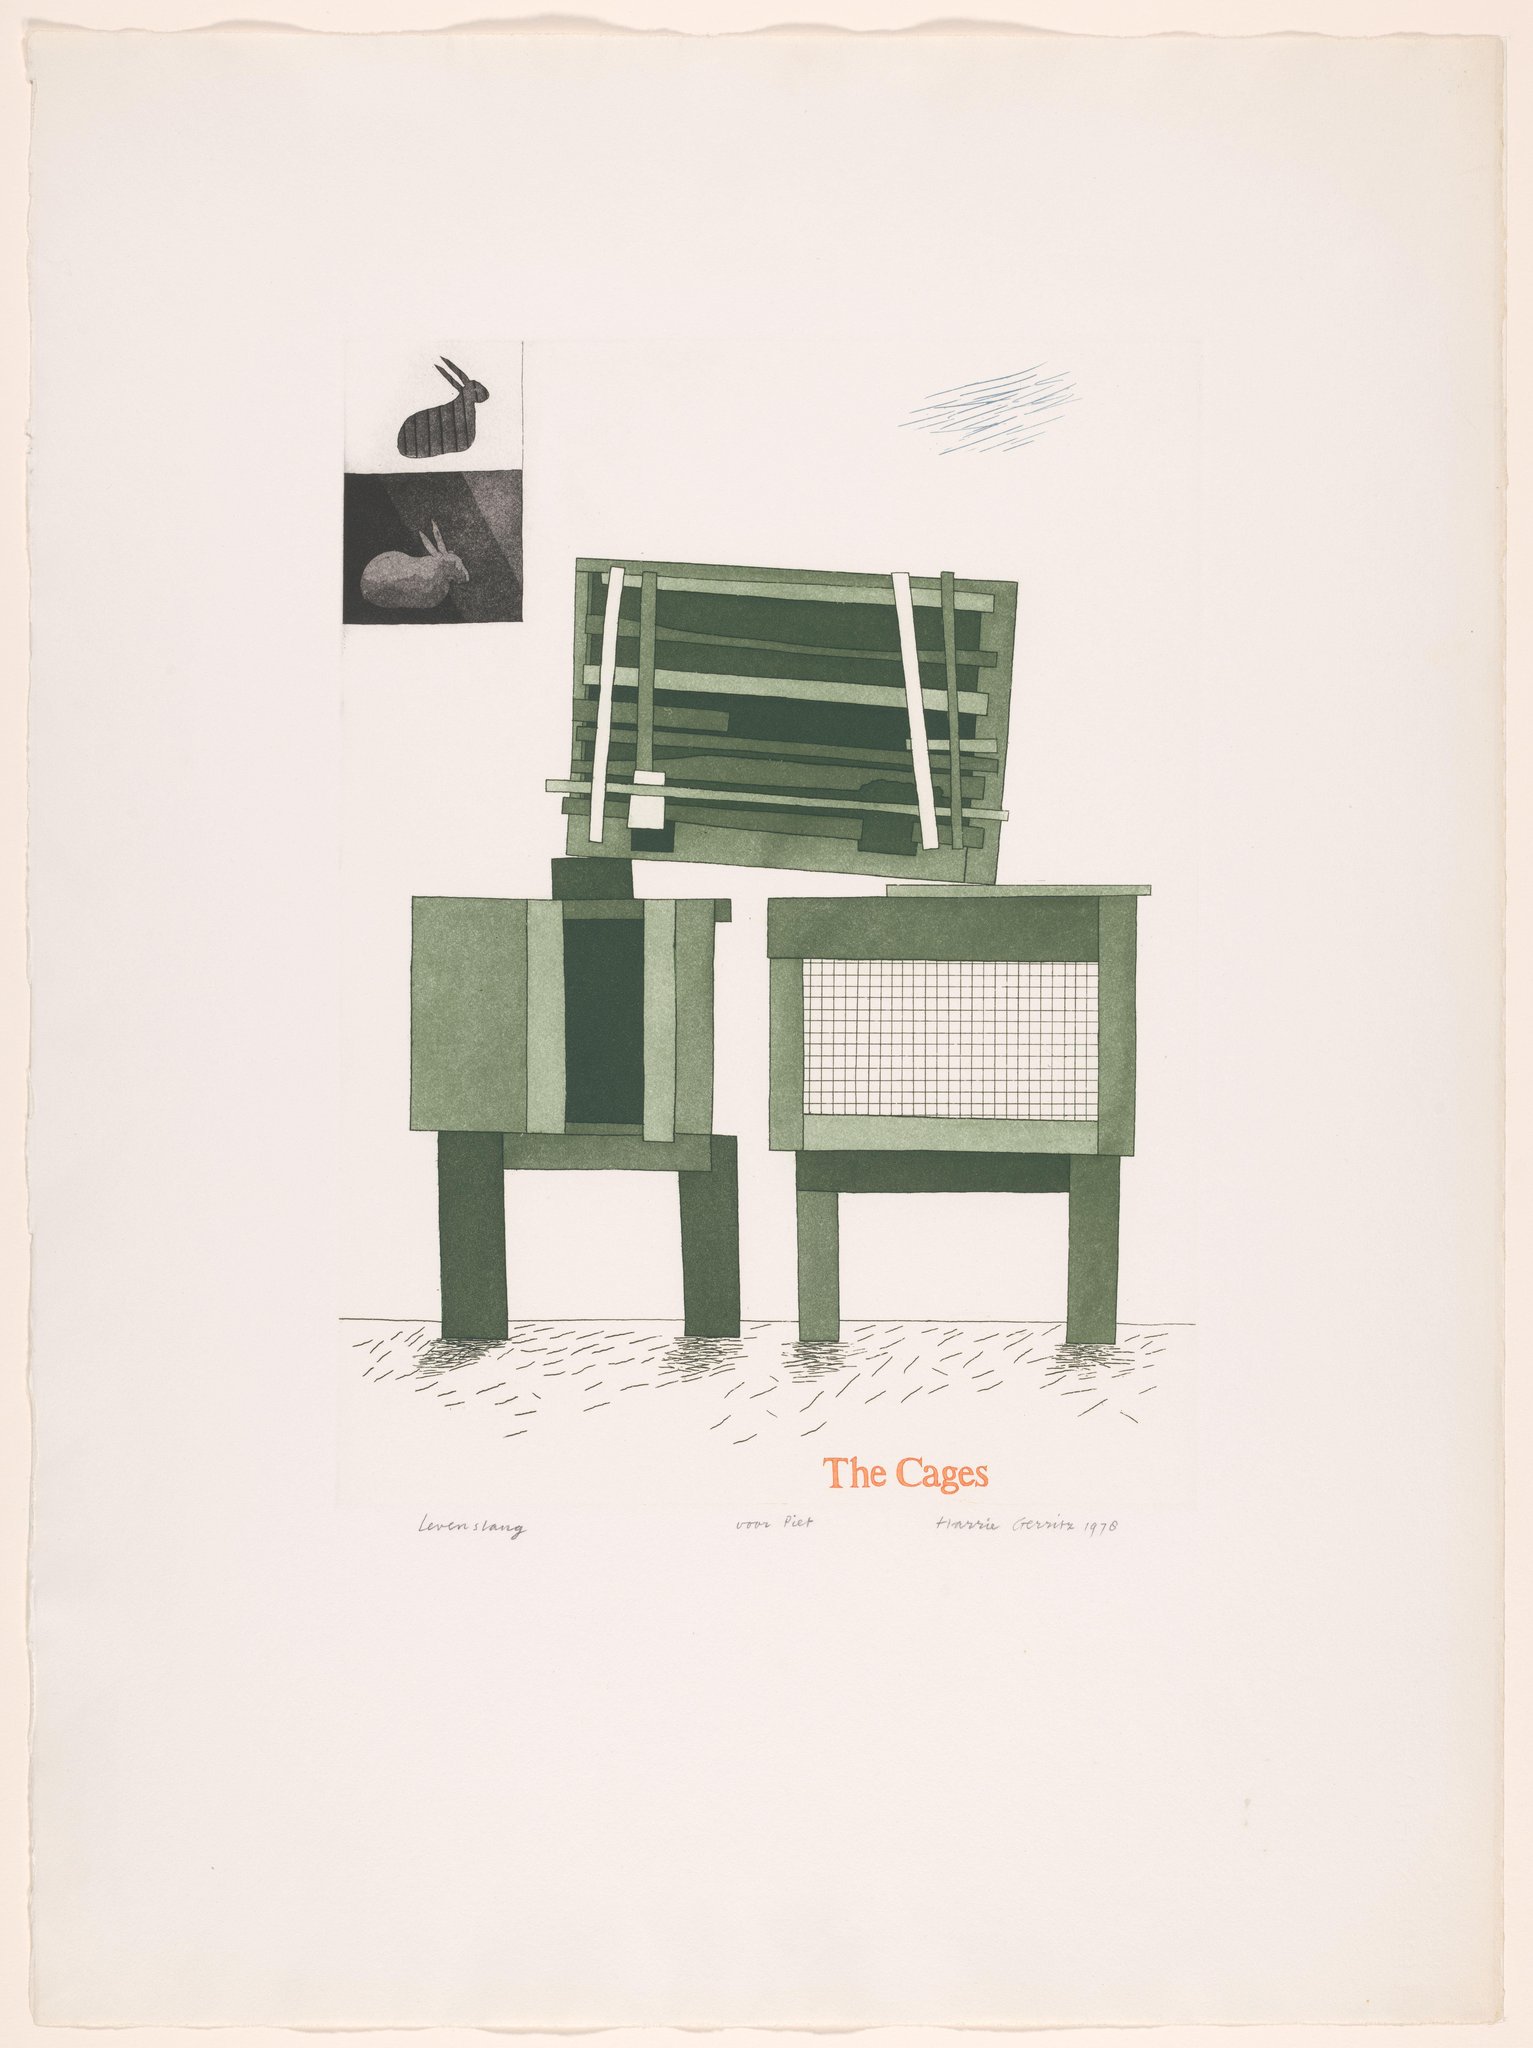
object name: print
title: Levenslang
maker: harrie a. gerritz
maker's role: draughtsman, painter, print maker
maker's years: 1940-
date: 1978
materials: paper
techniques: aquatint, etching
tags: domestic animals, kept in and outside the house (+ animal cage), rodents: rabbit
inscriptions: inscription: ‘PC’, dedication: ‘voor Piet’, collector's mark: Lugt 2228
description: Drie groene hokken en linksboven twee konijnen binnen een rechthoek.